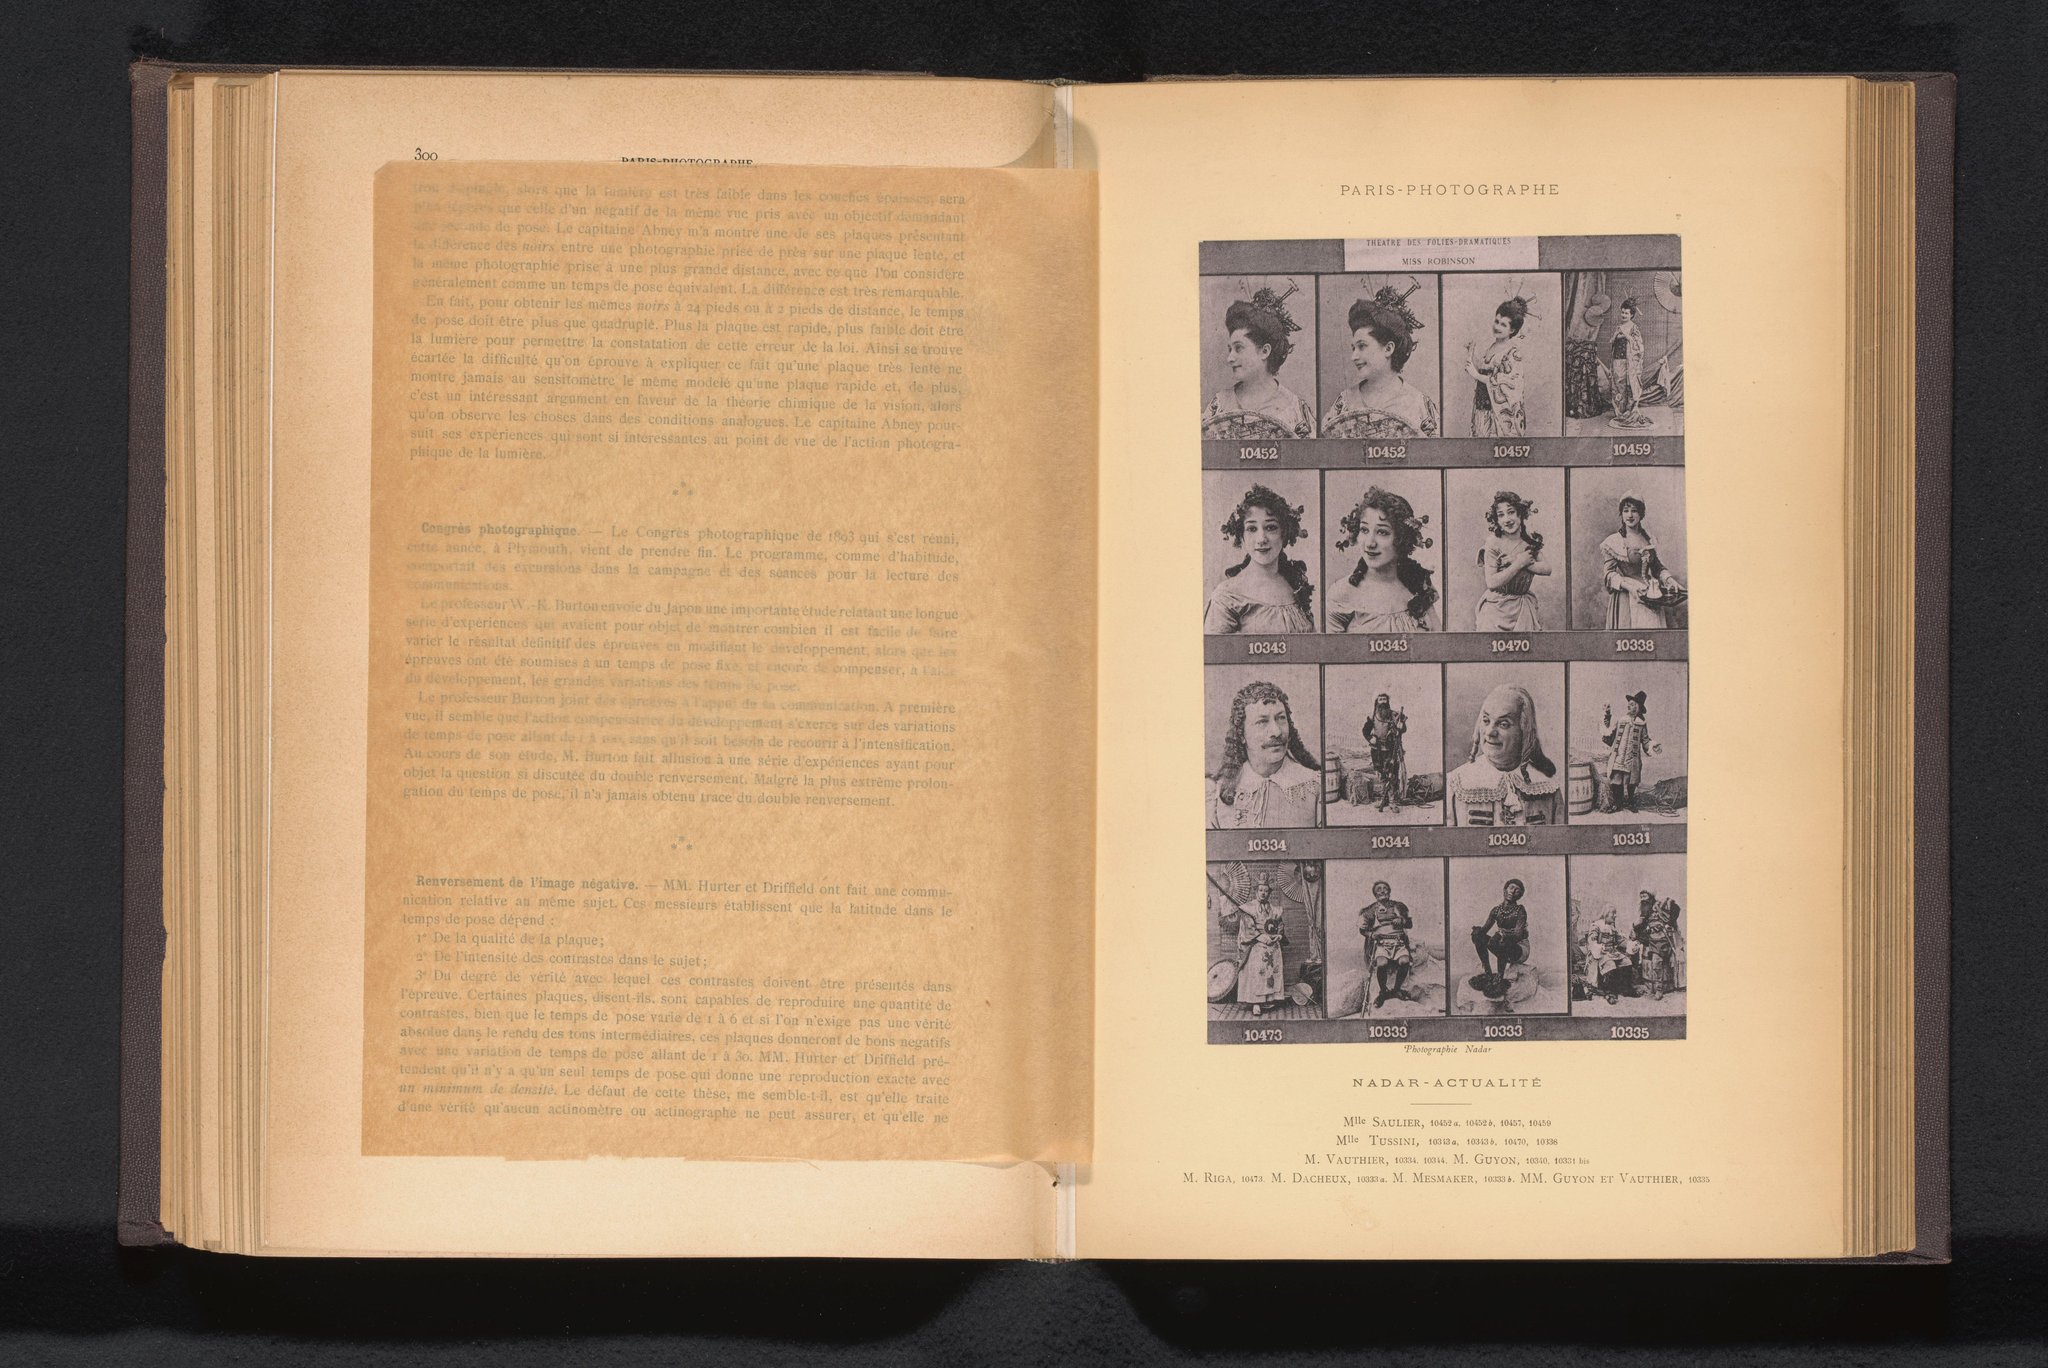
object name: page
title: Zestien portretten van acteurs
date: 1883-1893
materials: paper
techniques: photograph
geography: paris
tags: portrait of actor, actress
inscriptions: number: ‘10452A (...) 10335’, inscription: ‘Theatre des Folies-Dramatiques Miss Robinson (...)’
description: Van links naar rechts en van boven naar beneden: Jeanne Saulier, Mlle Tussini, M. Vauthier, M. Guyon, M. Riga, M. Dacheux en M. Mesmaker.